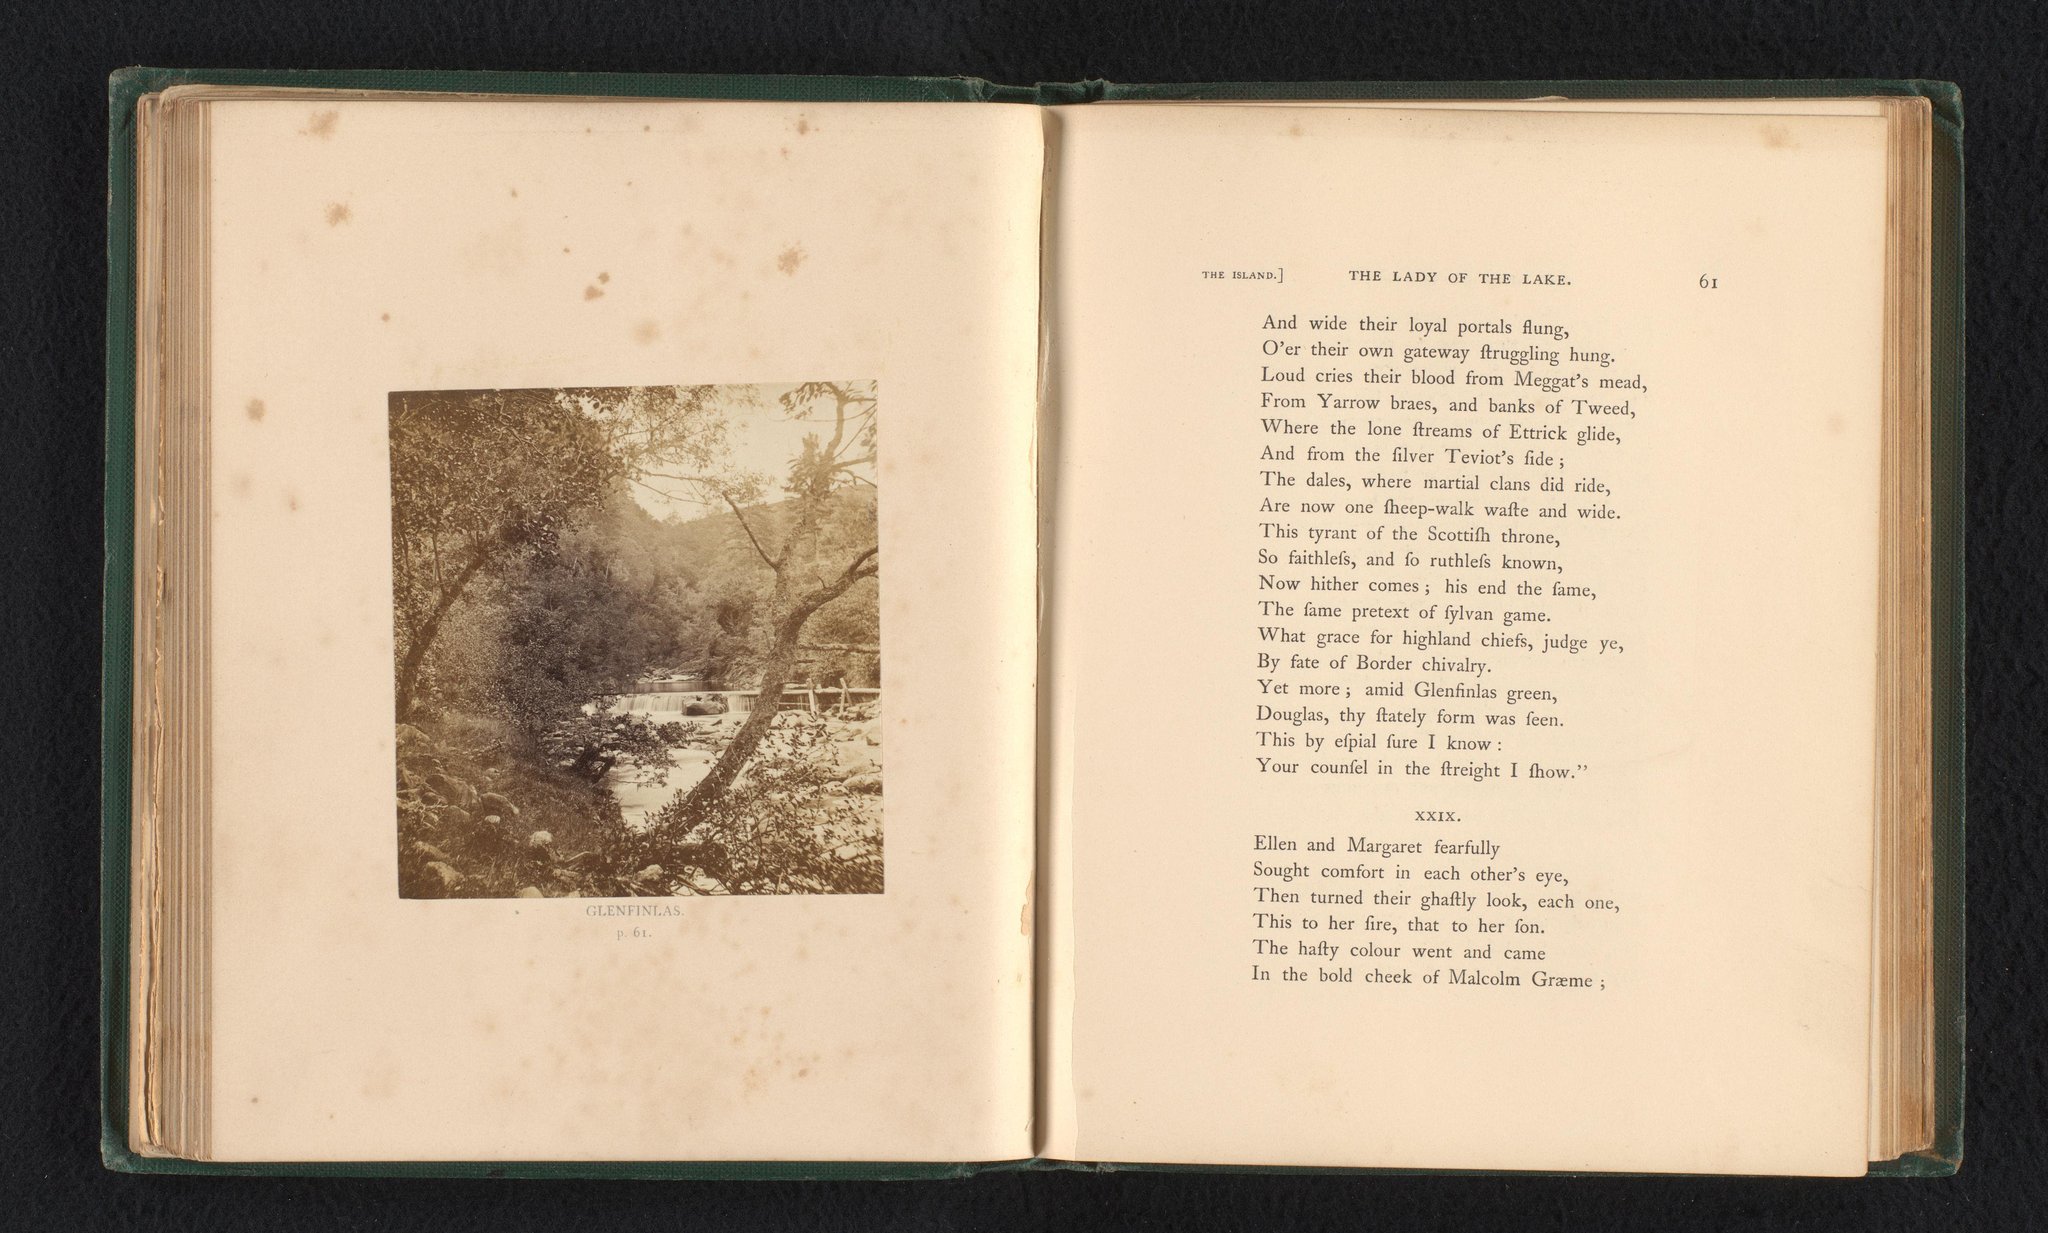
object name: page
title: Gezicht op een rivier in Glen Finglas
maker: thomas ogle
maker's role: fotograaf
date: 1858-1863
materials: paper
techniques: albumen print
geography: glen finglas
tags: river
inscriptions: number: ‘p. 61.’